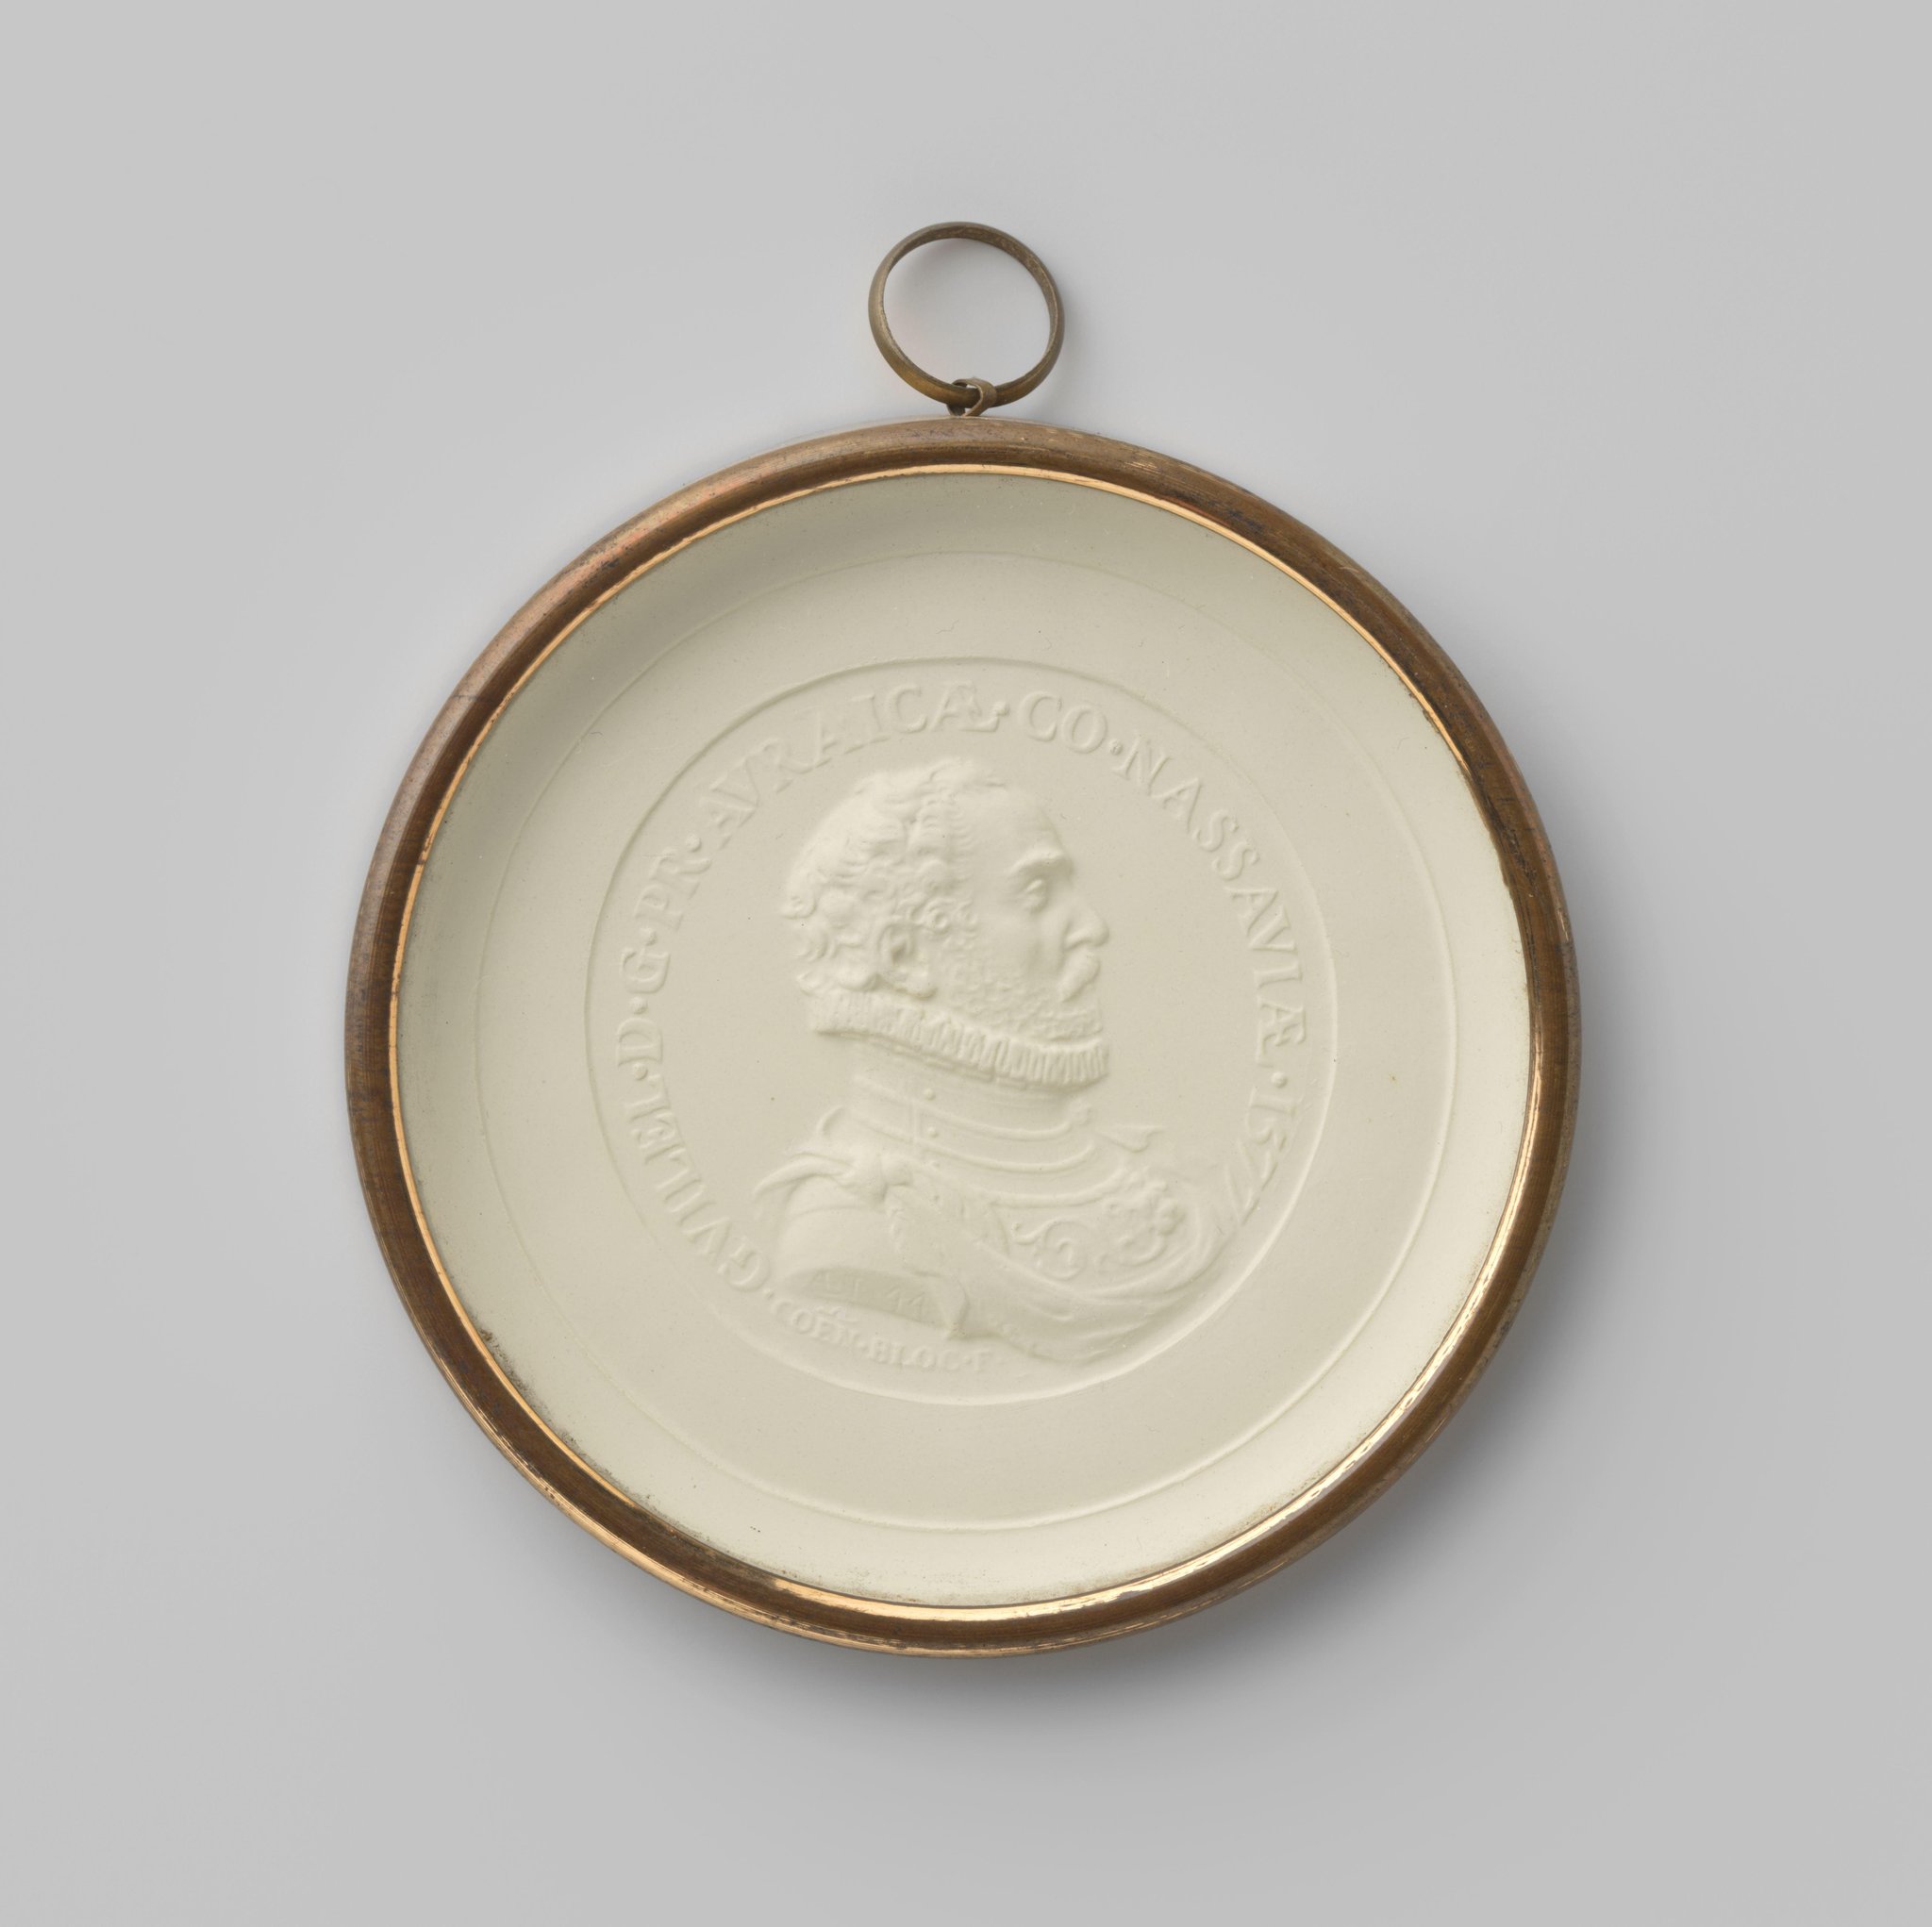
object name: locket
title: Willem I, prins van Oranje-Nassau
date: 1577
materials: brass, glass, gypsum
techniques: casting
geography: berlin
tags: william i (prince of orange)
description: Eenzijdig medaillon in messing ring achter glas aan draagoog en draagring. Voorzijde: borststuk man naar rechts binnen omschrift. Keerzijde: etiket met opschrift.